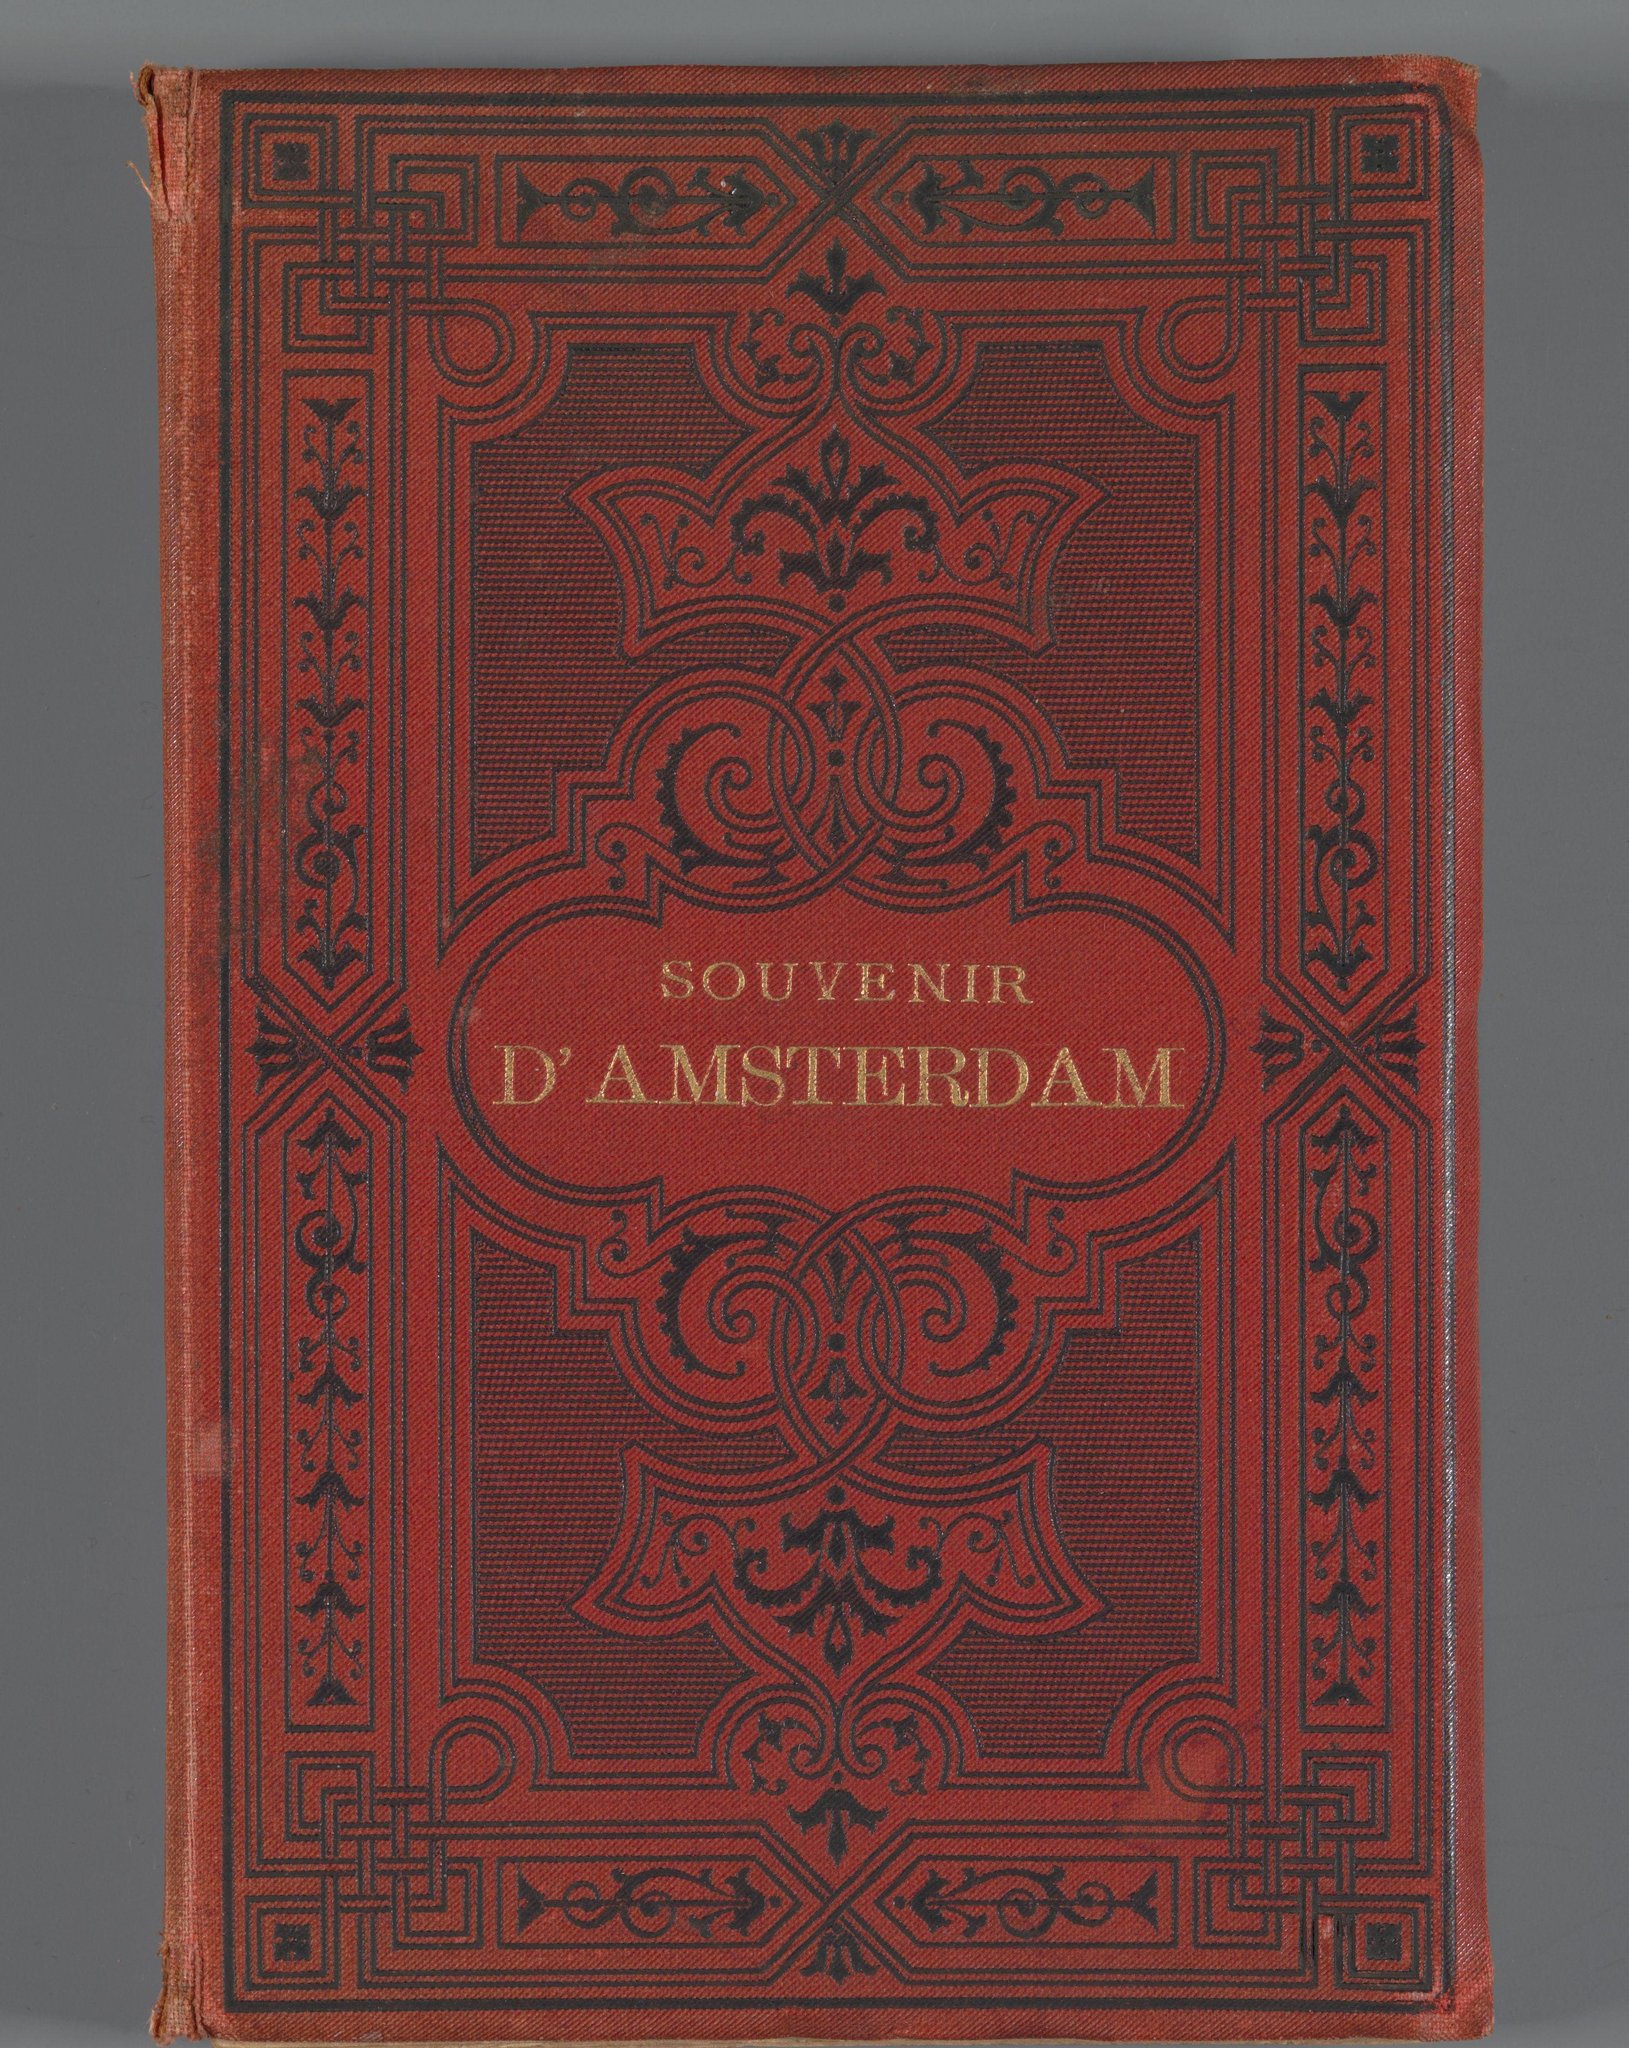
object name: accordion book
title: Souvenir d'Amsterdam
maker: andries jager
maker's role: publisher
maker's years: 1825-1905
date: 1860-1900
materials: cardboard, linen, paper, photographic support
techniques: albumen print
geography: amsterdam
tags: prospect of city, town panorama, silhouette of city, amsterdam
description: Leporelloalbum in rode linnen band met op de voorzijde in gouddruk de titel. Het voorplat is versierd met geometrische en plantmotieven in zwart. Het album bevat twaalf aan elkaar vastzittende, uitklapbare kartonnen bladen met daarop in totaal twaalf foto's. Het zijn opnames van stadsgezichten in het oude centrum van Amsterdam: gebouwen, pleinen, straten en grachten.